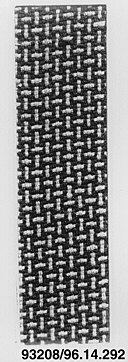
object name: piece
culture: japanese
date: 1701-1900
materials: silk